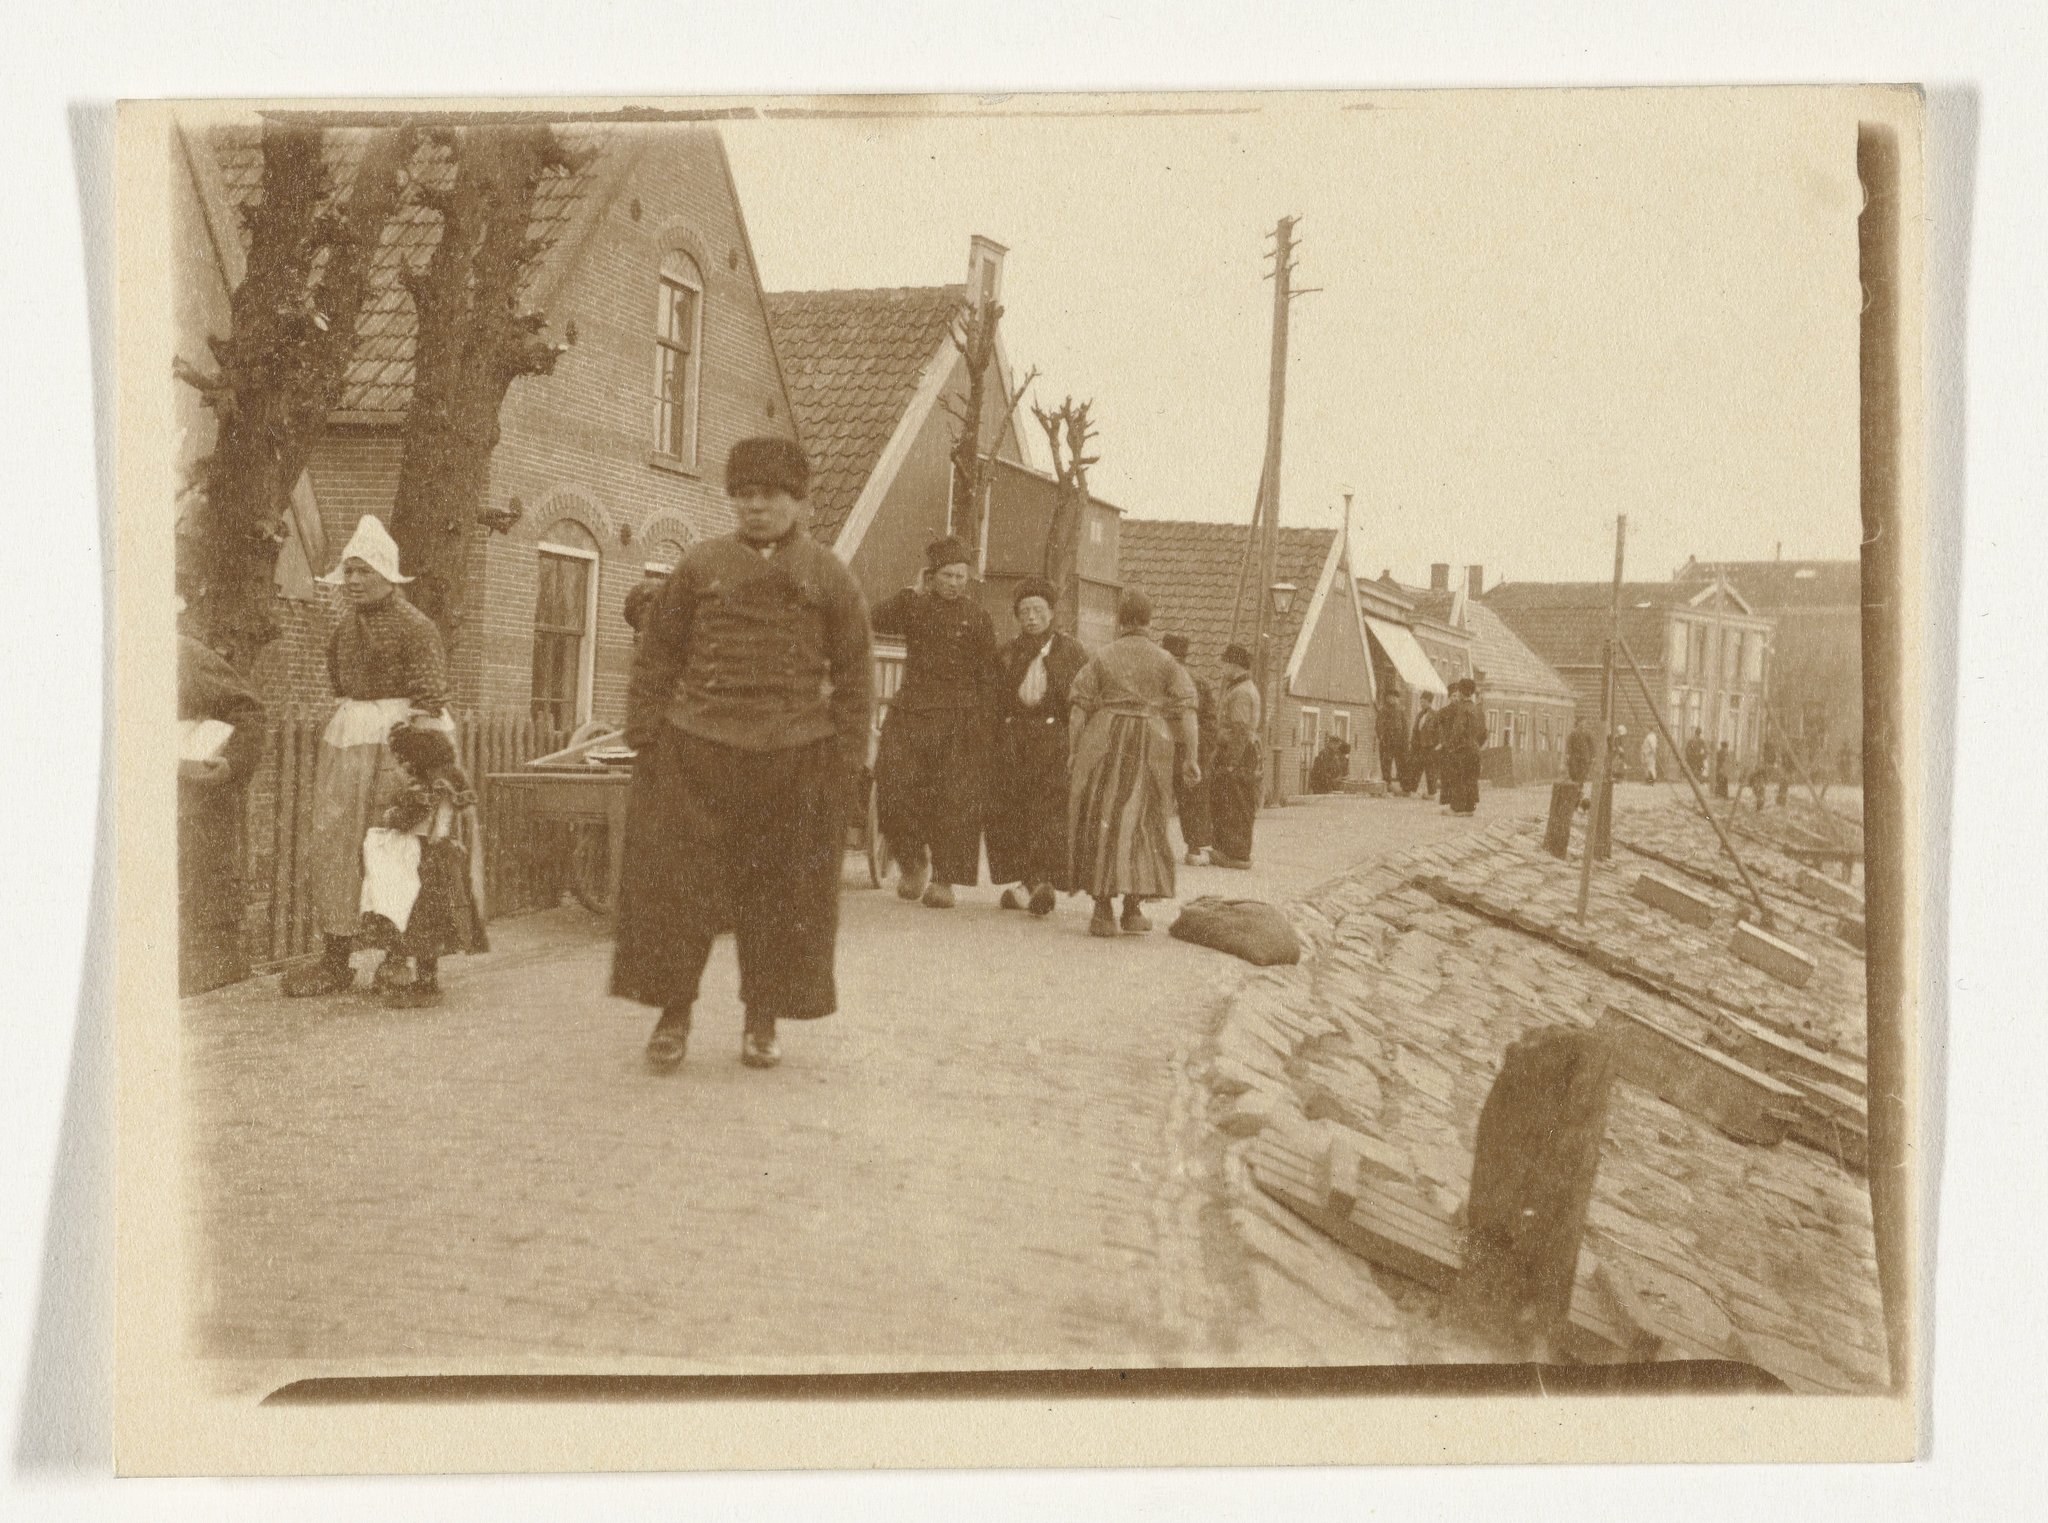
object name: photograph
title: Gezicht op een dijk in Volendam met mensen in klederdracht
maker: george hidderley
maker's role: fotograaf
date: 1900-1910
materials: photographic support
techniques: salted paper print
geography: volendam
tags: folk costume, regional costume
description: Was oorspronkelijk los ingevoegd in album RP-F-2002-105